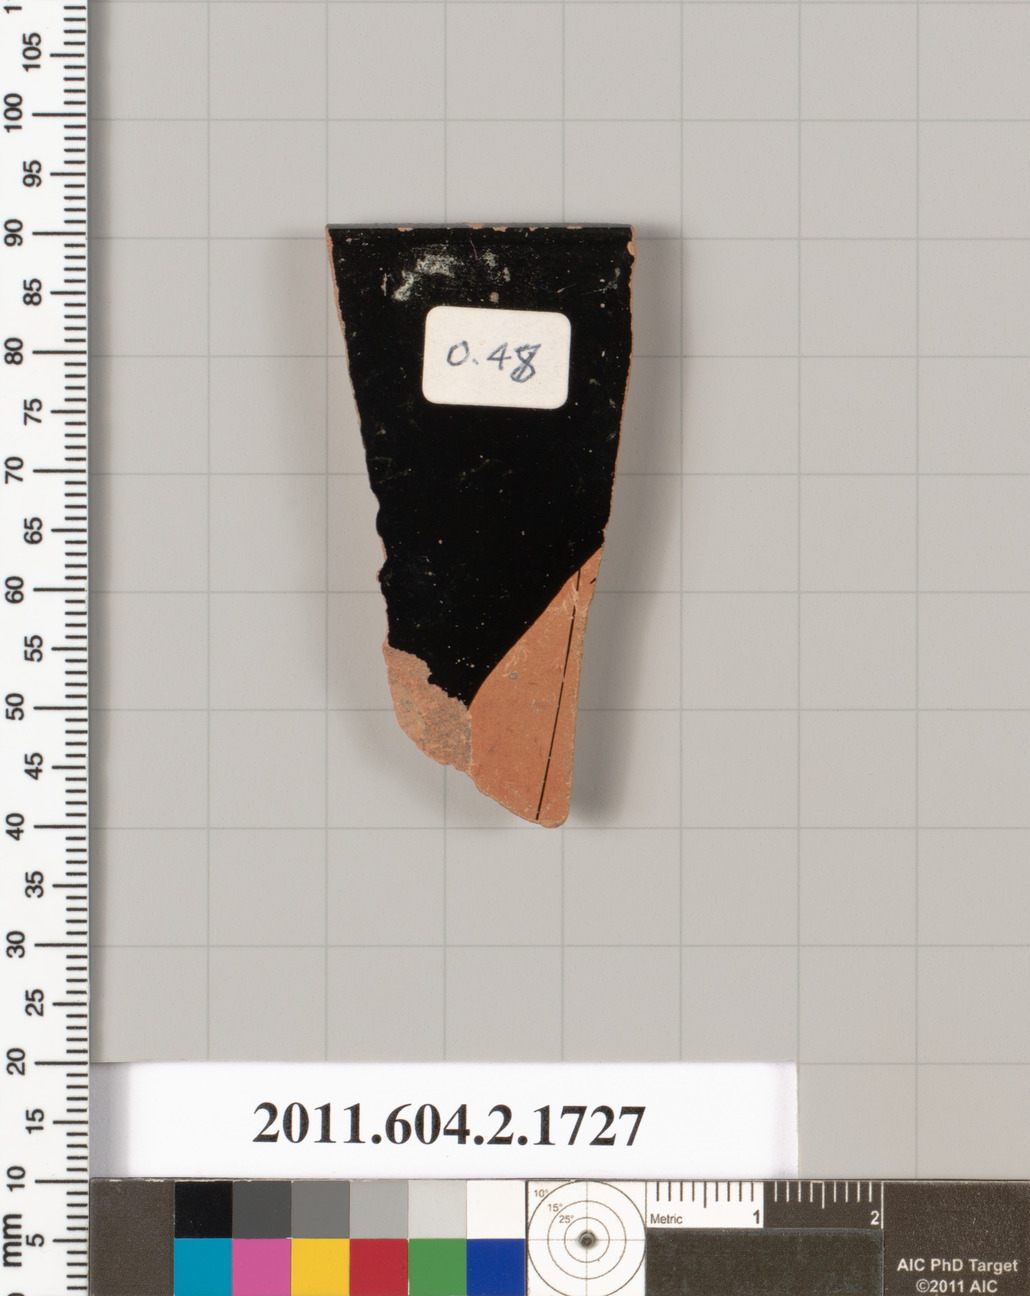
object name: skyphos fragment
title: Terracotta rim fragment of a skyphos (deep drinking cup)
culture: greek, attic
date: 475-451 BCE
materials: terracotta